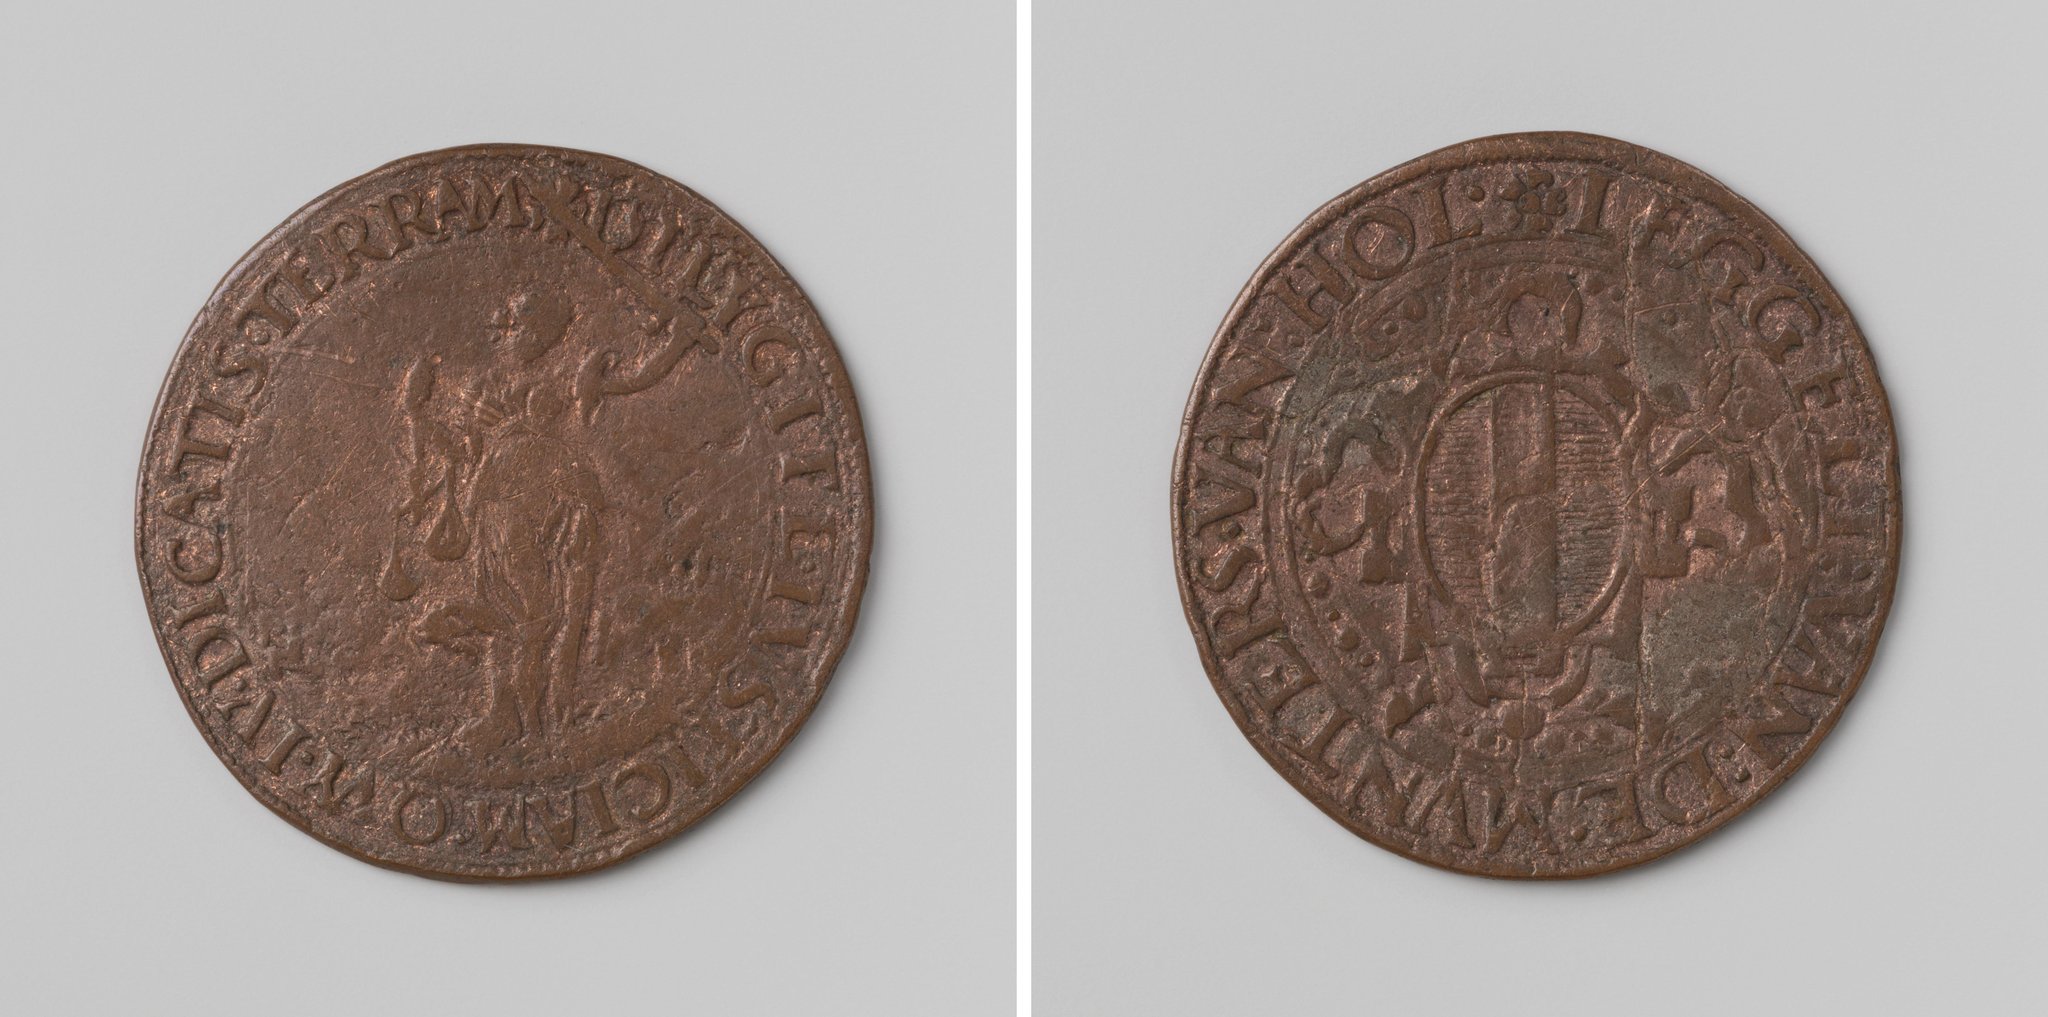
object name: jeton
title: Maria van Hongarije doet te Brussel afstand van de voogdij over de Nederlanden, ten gunst van Filips, erfprins van Spanje, rekenpenning van de munt van Holland te Dordrecht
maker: Anonymous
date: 1555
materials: copper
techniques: striking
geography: dordrecht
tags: philip ii of spain, brussels, maria van hongarije (landvoogdes der nederlanden), dordrecht, low countries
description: Koperen penning. Voorzijde: Gerechtigheid met weegschaal in rechter- en getrokken zwaard in linkerhand binnen omschrift. Keerzijde: wapenschild in cartouche binnen omschrift